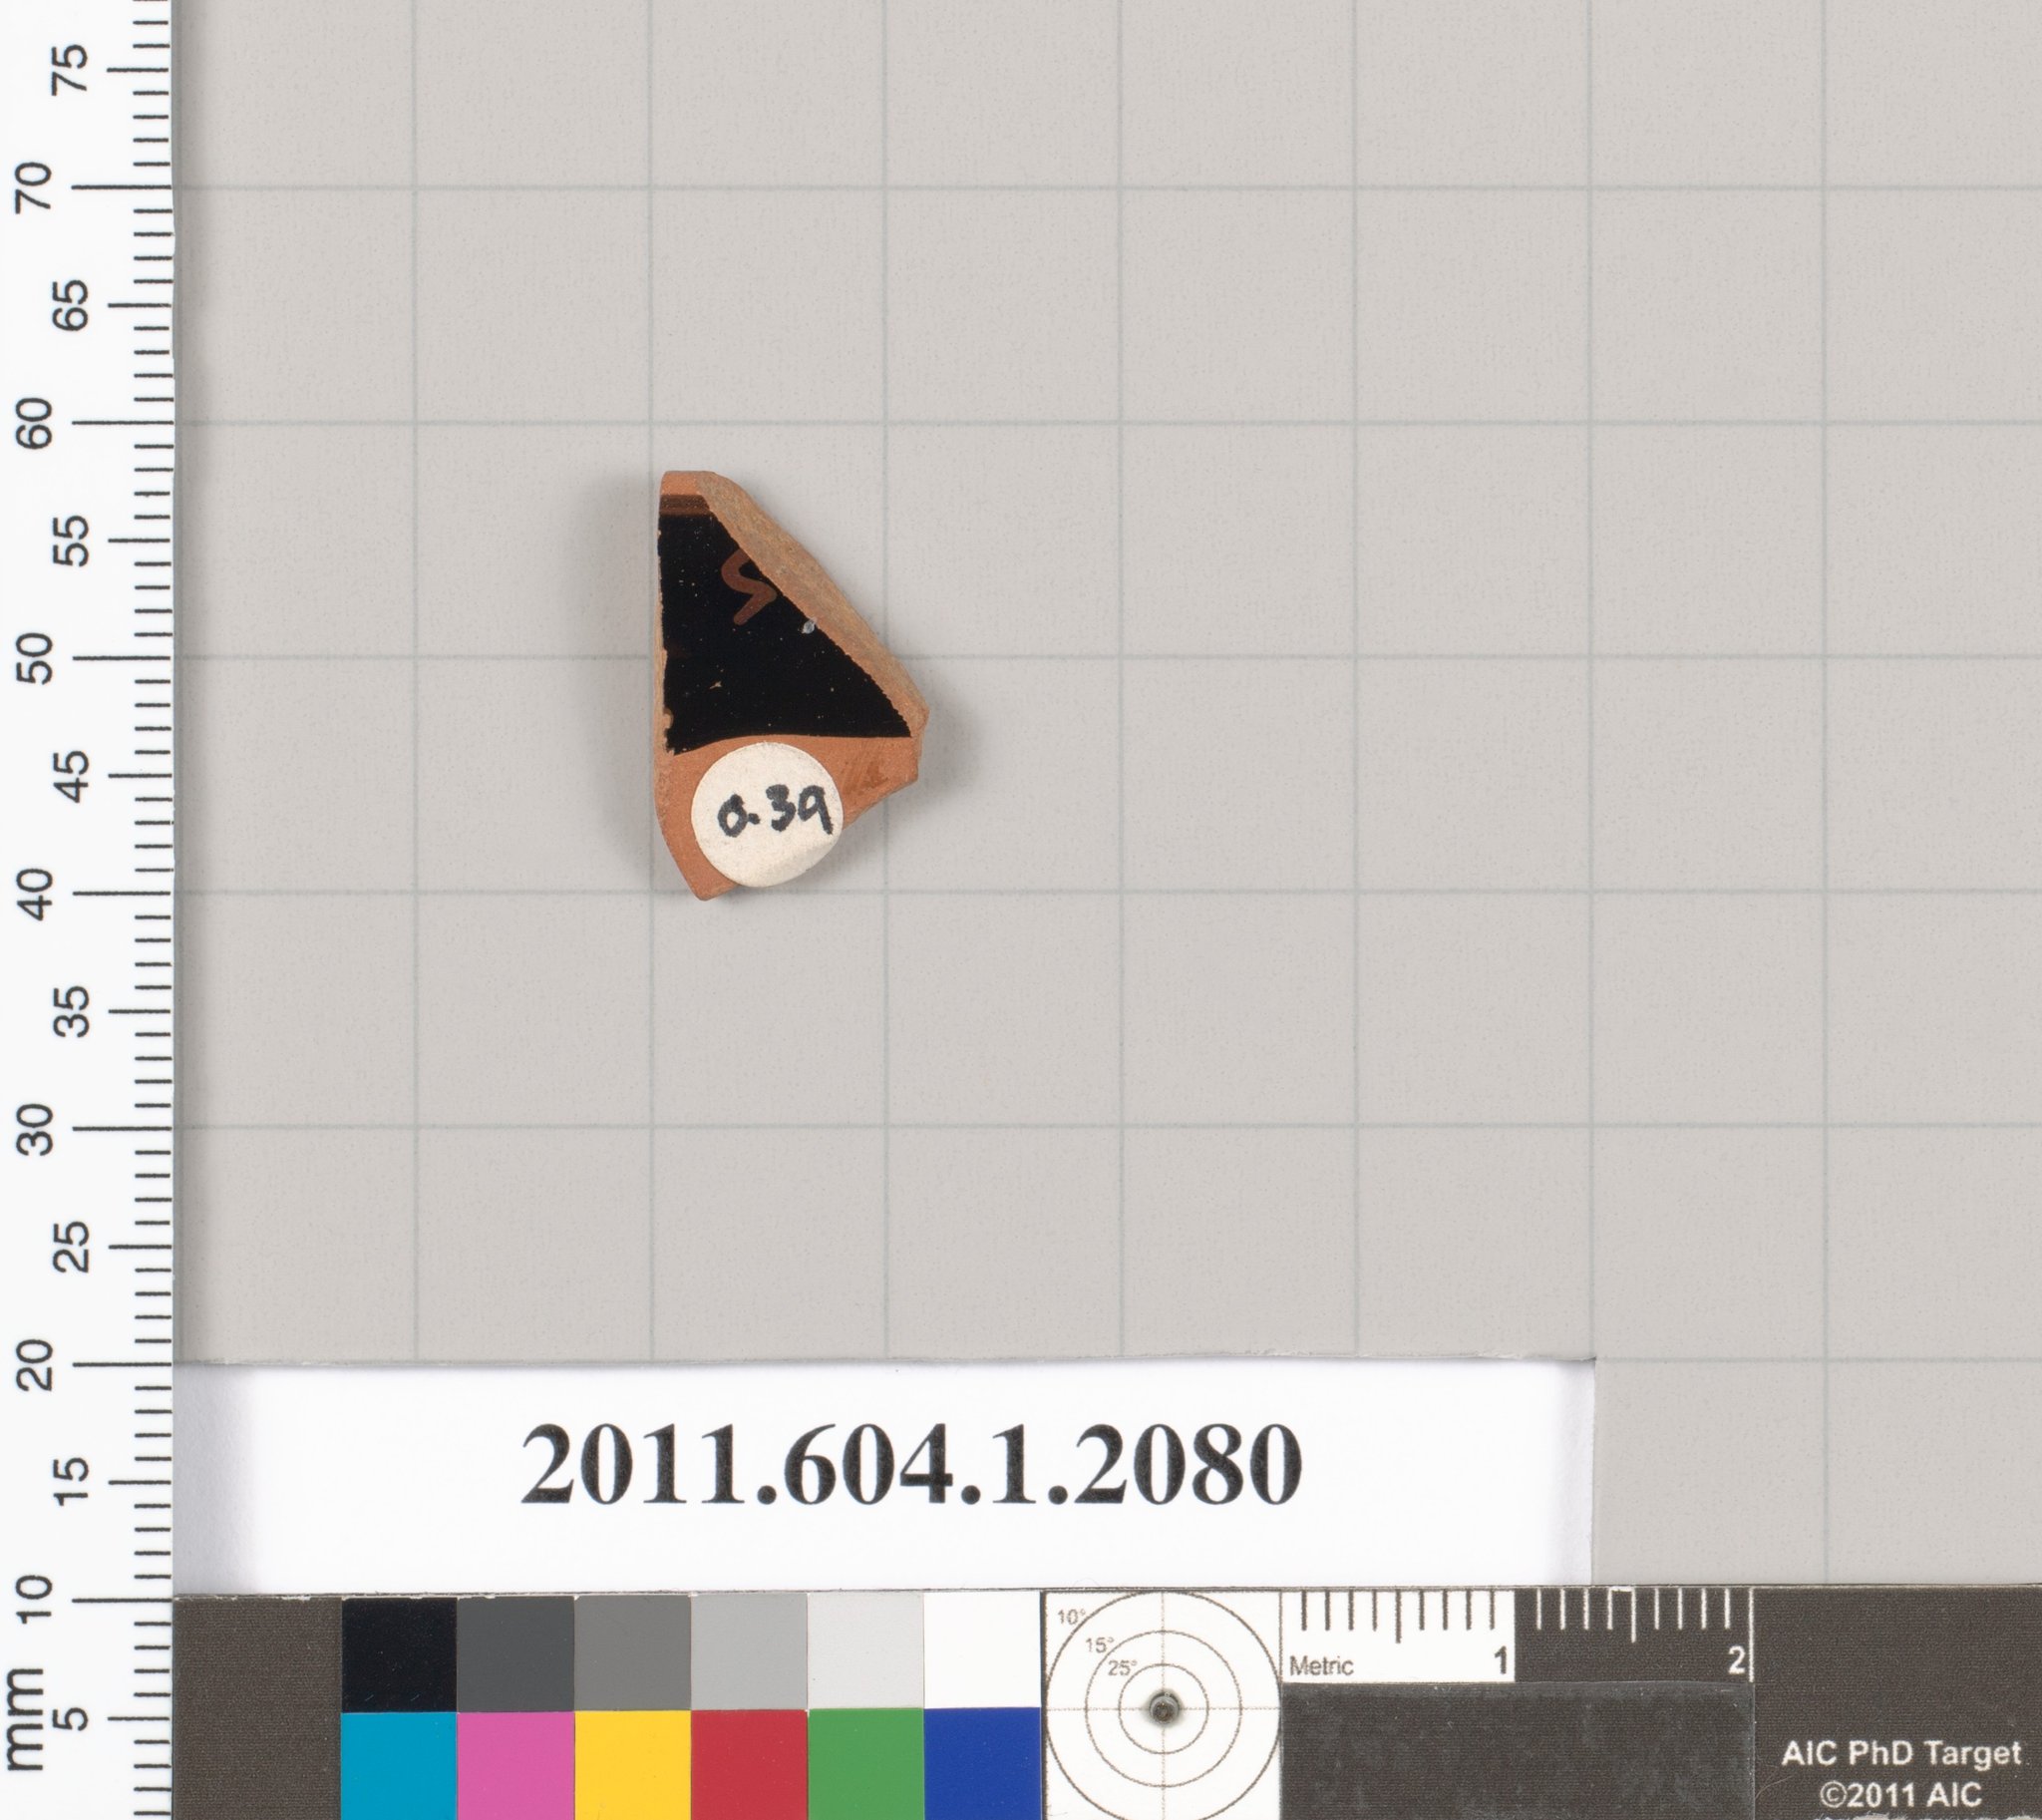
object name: kylix fragment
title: Terracotta rim fragment of a kylix (drinking cup)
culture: greek, attic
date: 500-401 BCE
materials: terracotta